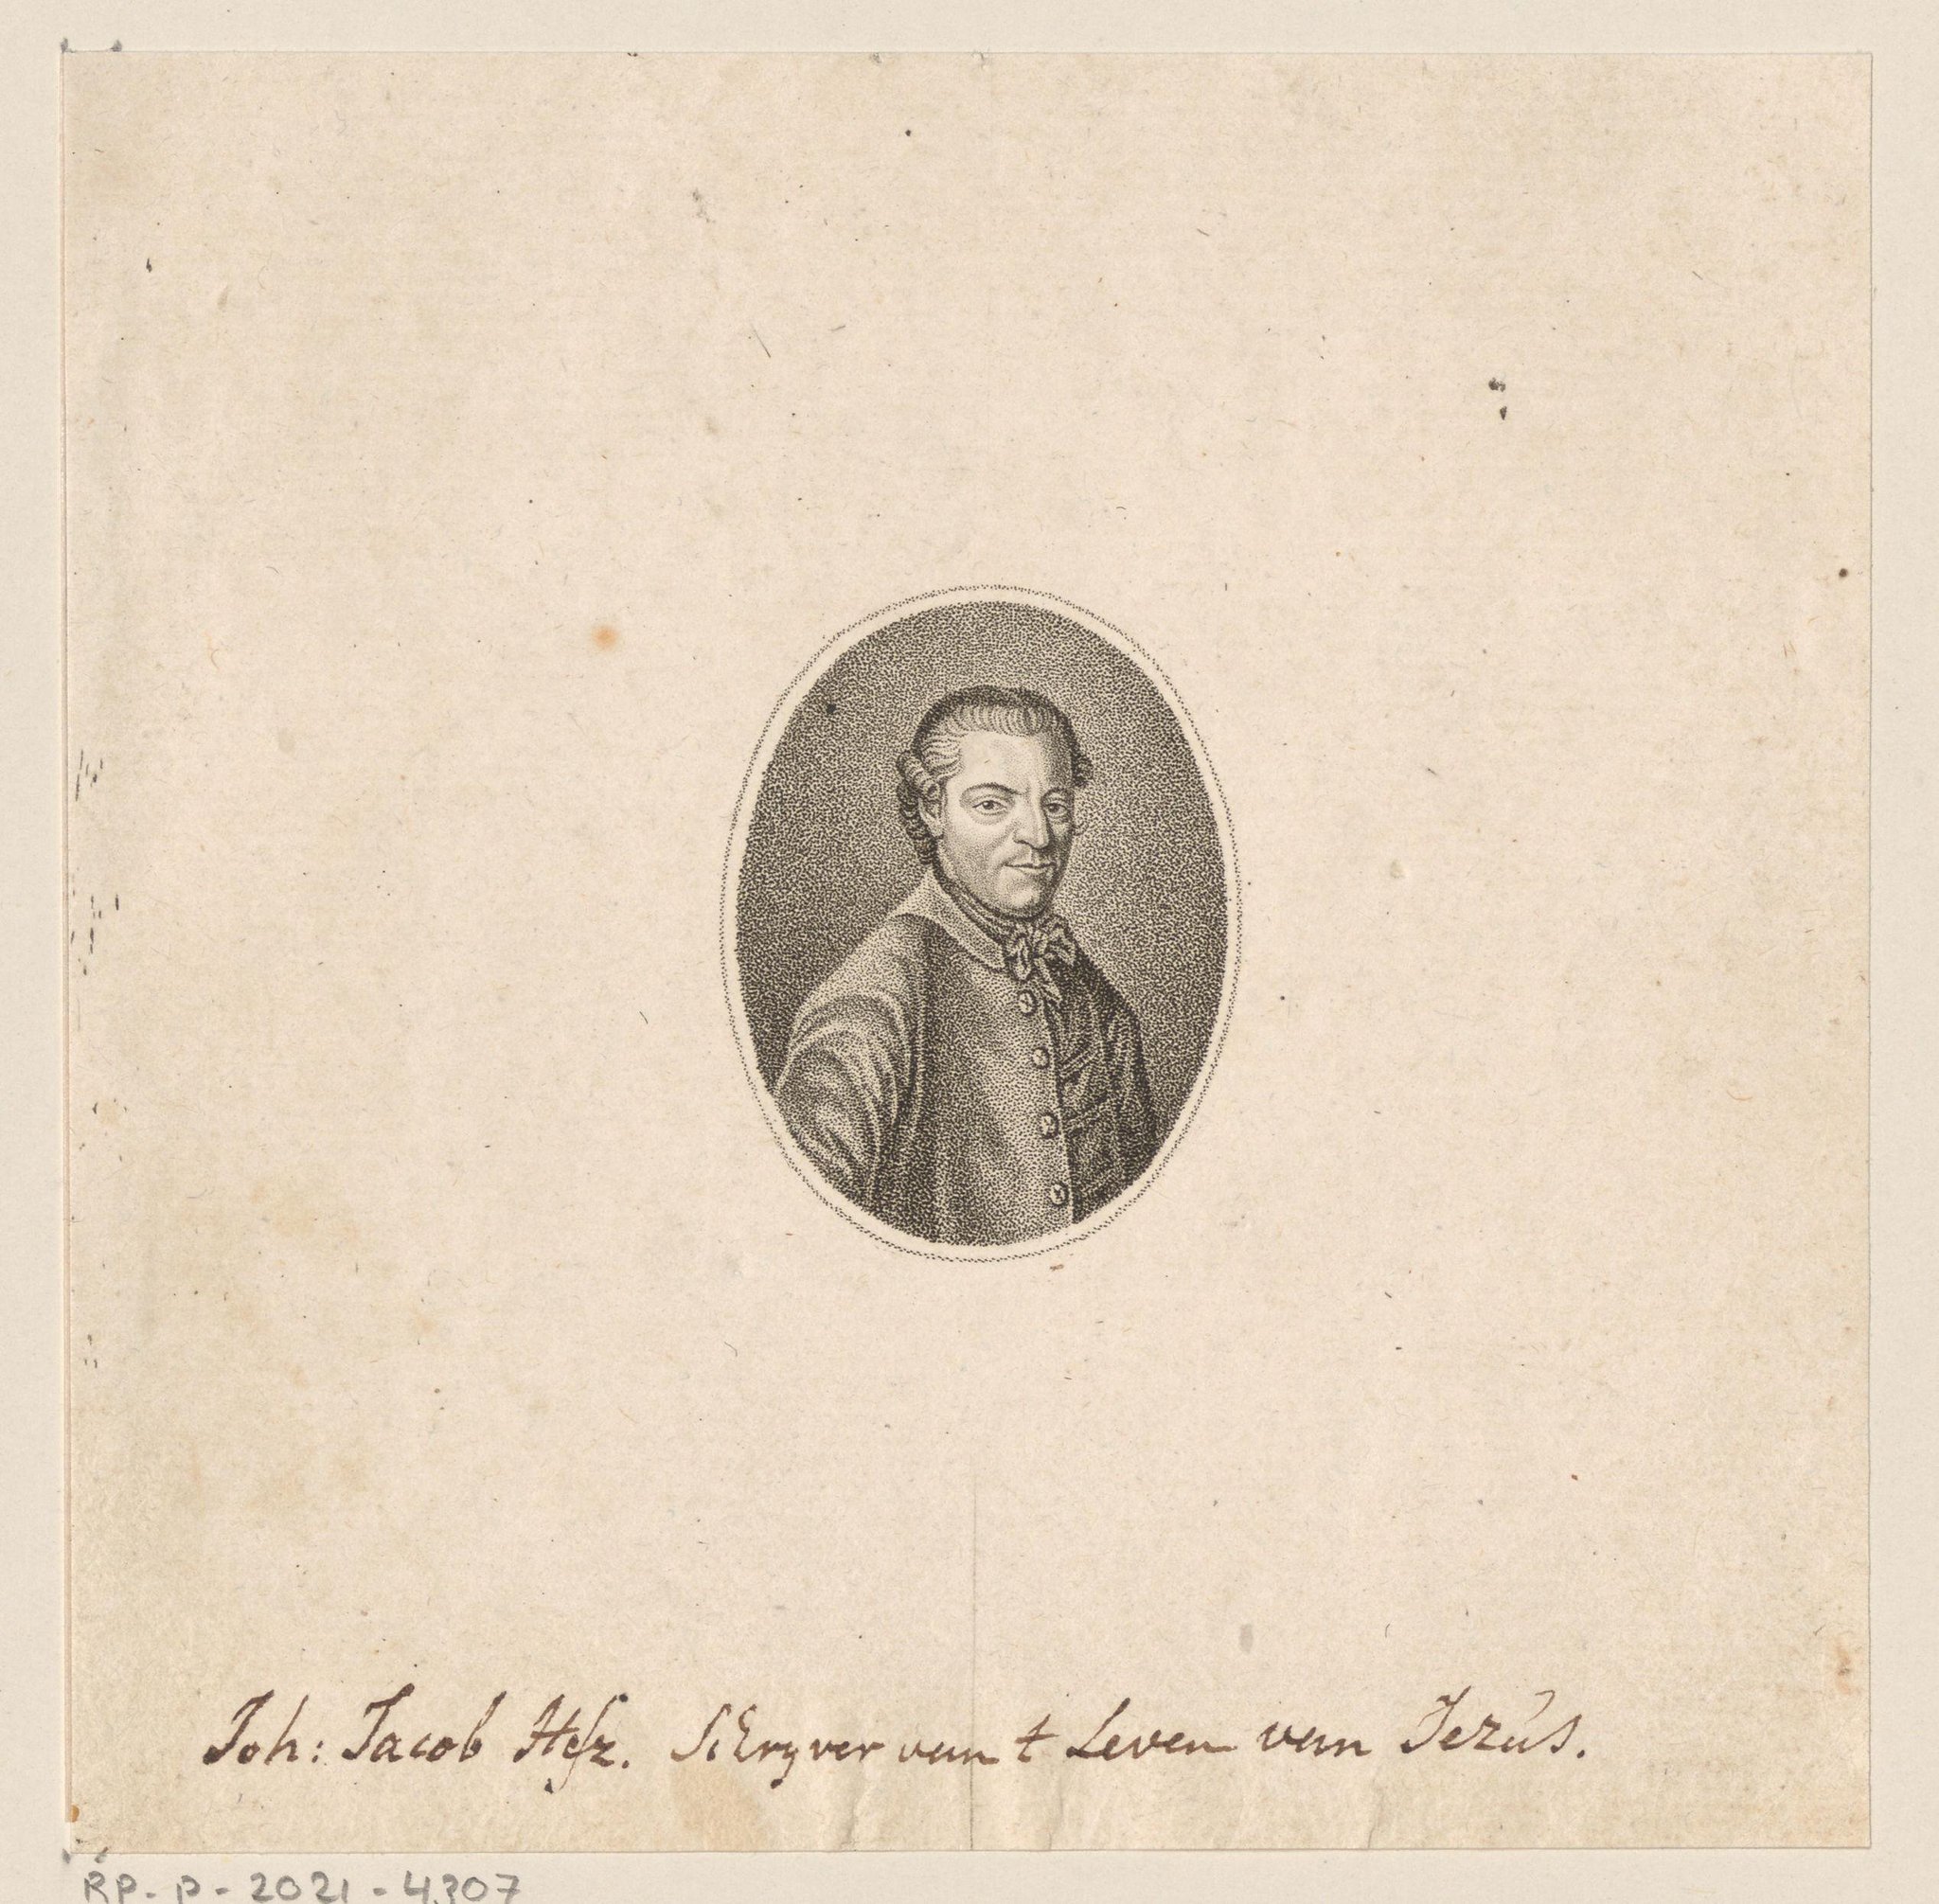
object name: print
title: Portret van Johann Jakob Hess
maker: Anonymous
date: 1775-1825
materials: paper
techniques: stippling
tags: historical persons, portrait of a writer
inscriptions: inscription: ‘Joh: Jacob Hesz. Schryver vant Leven van Jezus’